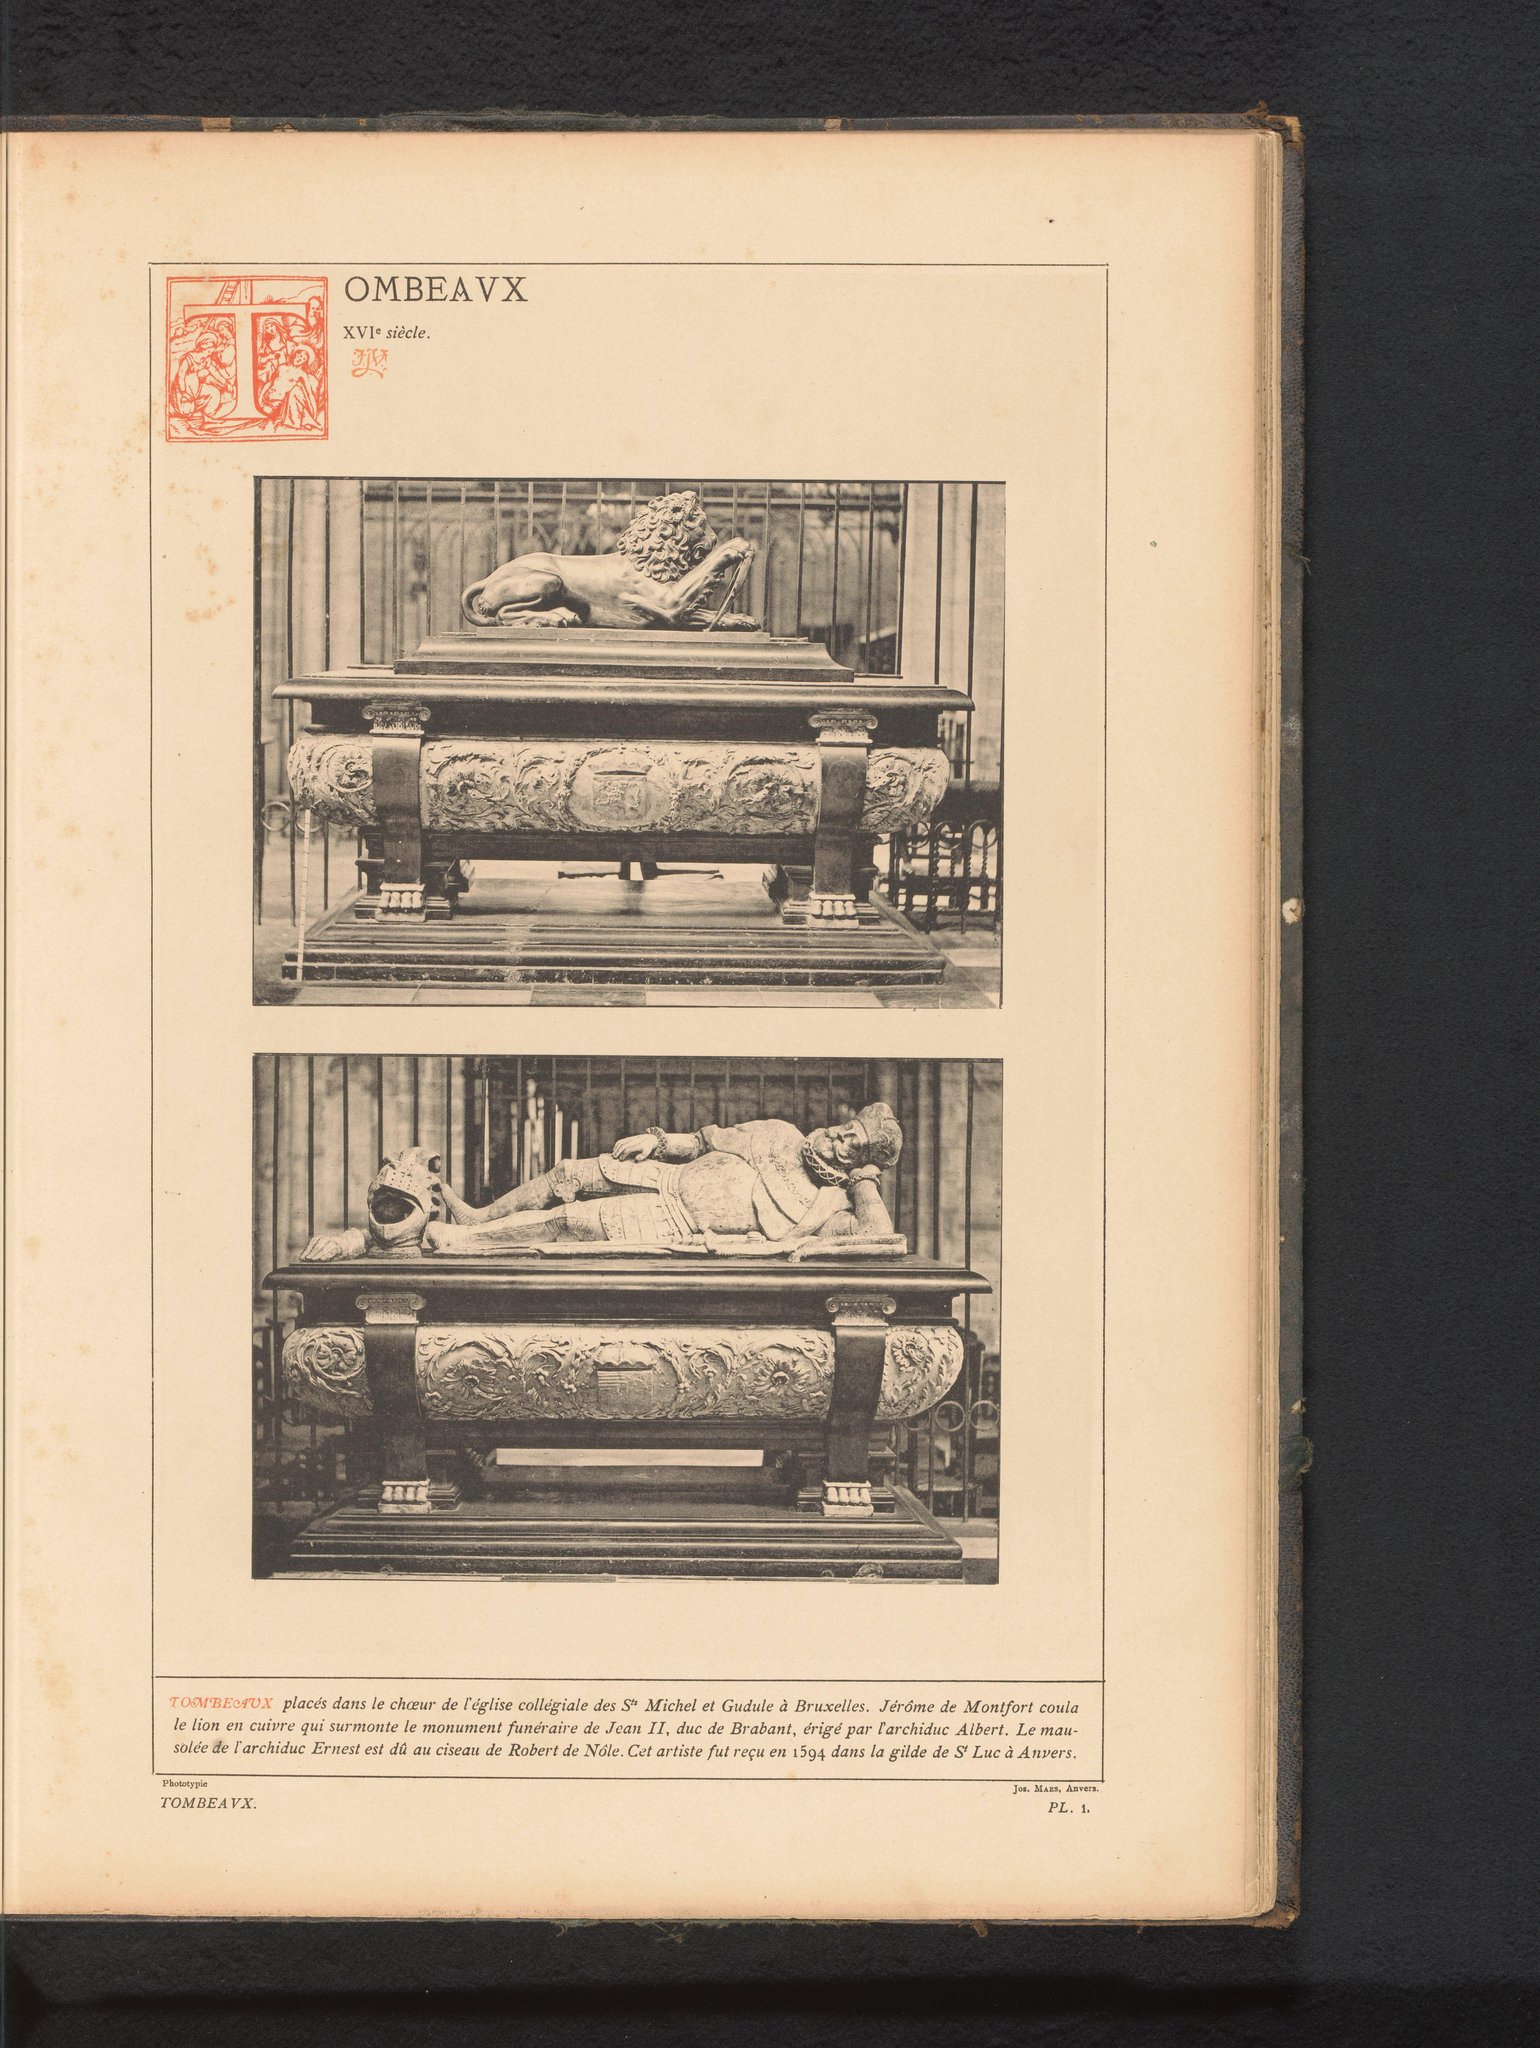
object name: page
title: Graftombe van hertog Jan II van Brabant en graftombe van aartshertog Ernest van Oostenrijk in de Sint-Michiel-en-Sint-Goedelekathedraal in Brussel, België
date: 1882-1887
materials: paper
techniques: photograph, photolithography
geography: sint-michiel en sint-goedelekathedraal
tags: brussels, gravestone, tombstone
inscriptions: inscription: ‘TOMBEAUX. - PL. 1.’, monogram: ‘JJvY’, inscription: ‘TOMBEAUX placés dans (...)’